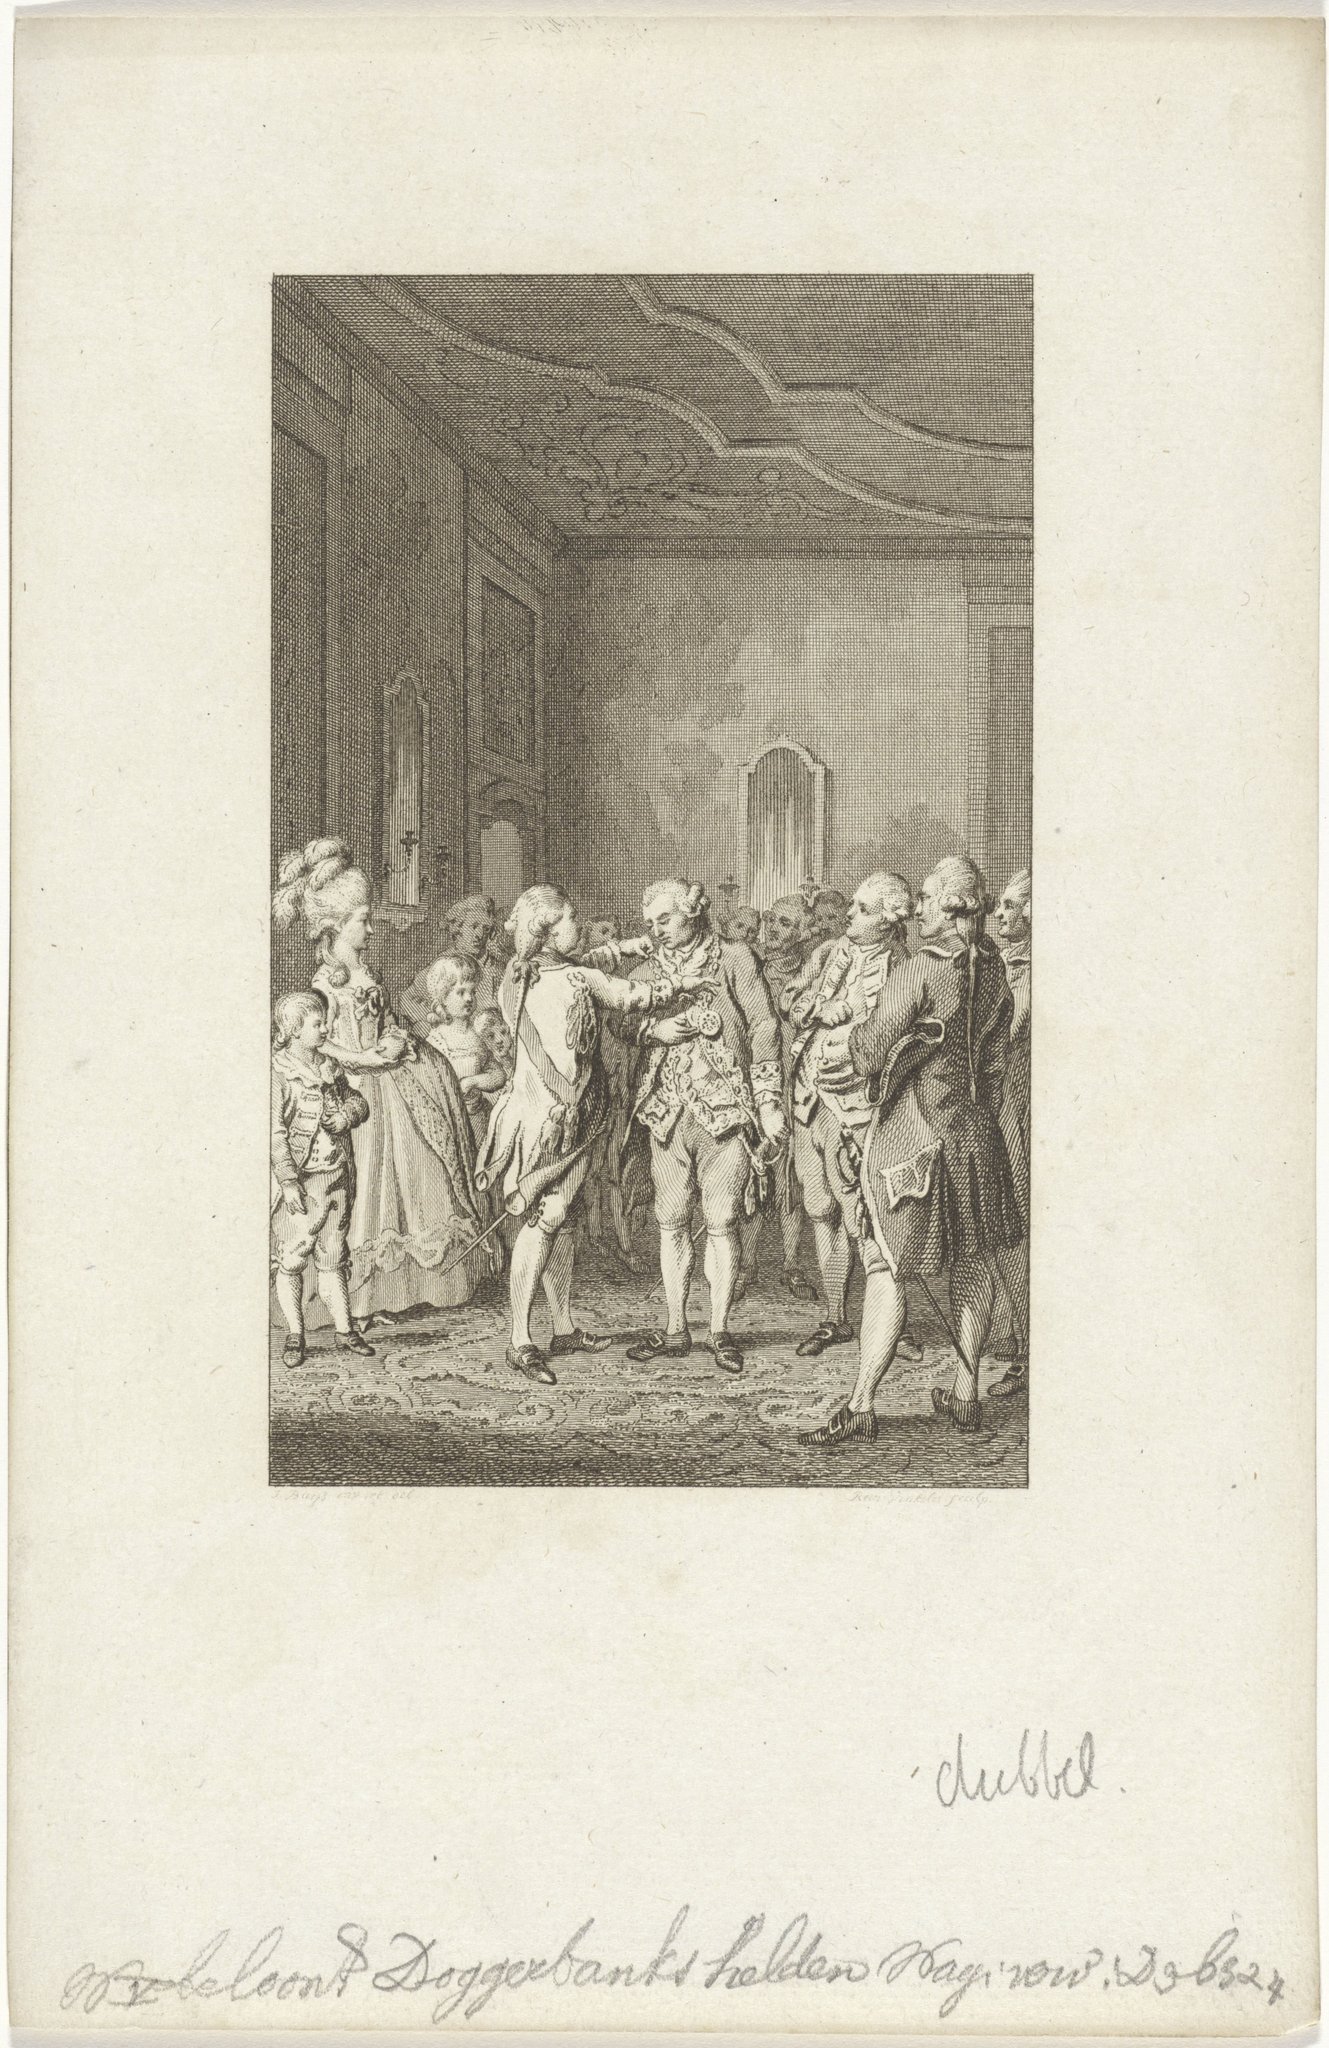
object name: history print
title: Willem V vereert de helden van de zeeslag bij Doggersbank, 1781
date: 1788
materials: paper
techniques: engraving, etching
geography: amsterdam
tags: william v (prince of orange), johan arnold zoutman, medals and other marks of military honour (+ sailing-ships)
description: Gebruikt als illustratie in: P.A. Loosjes. Vaderlandsche historie, vervattende de geschiedenissen, der Vereenigde Nederlanden (...). Ten onmiddelyken vervolge van Wagenaar's Vaderlandsche historie. Dl. 3. Amsterdam: J. Allart, 1788.